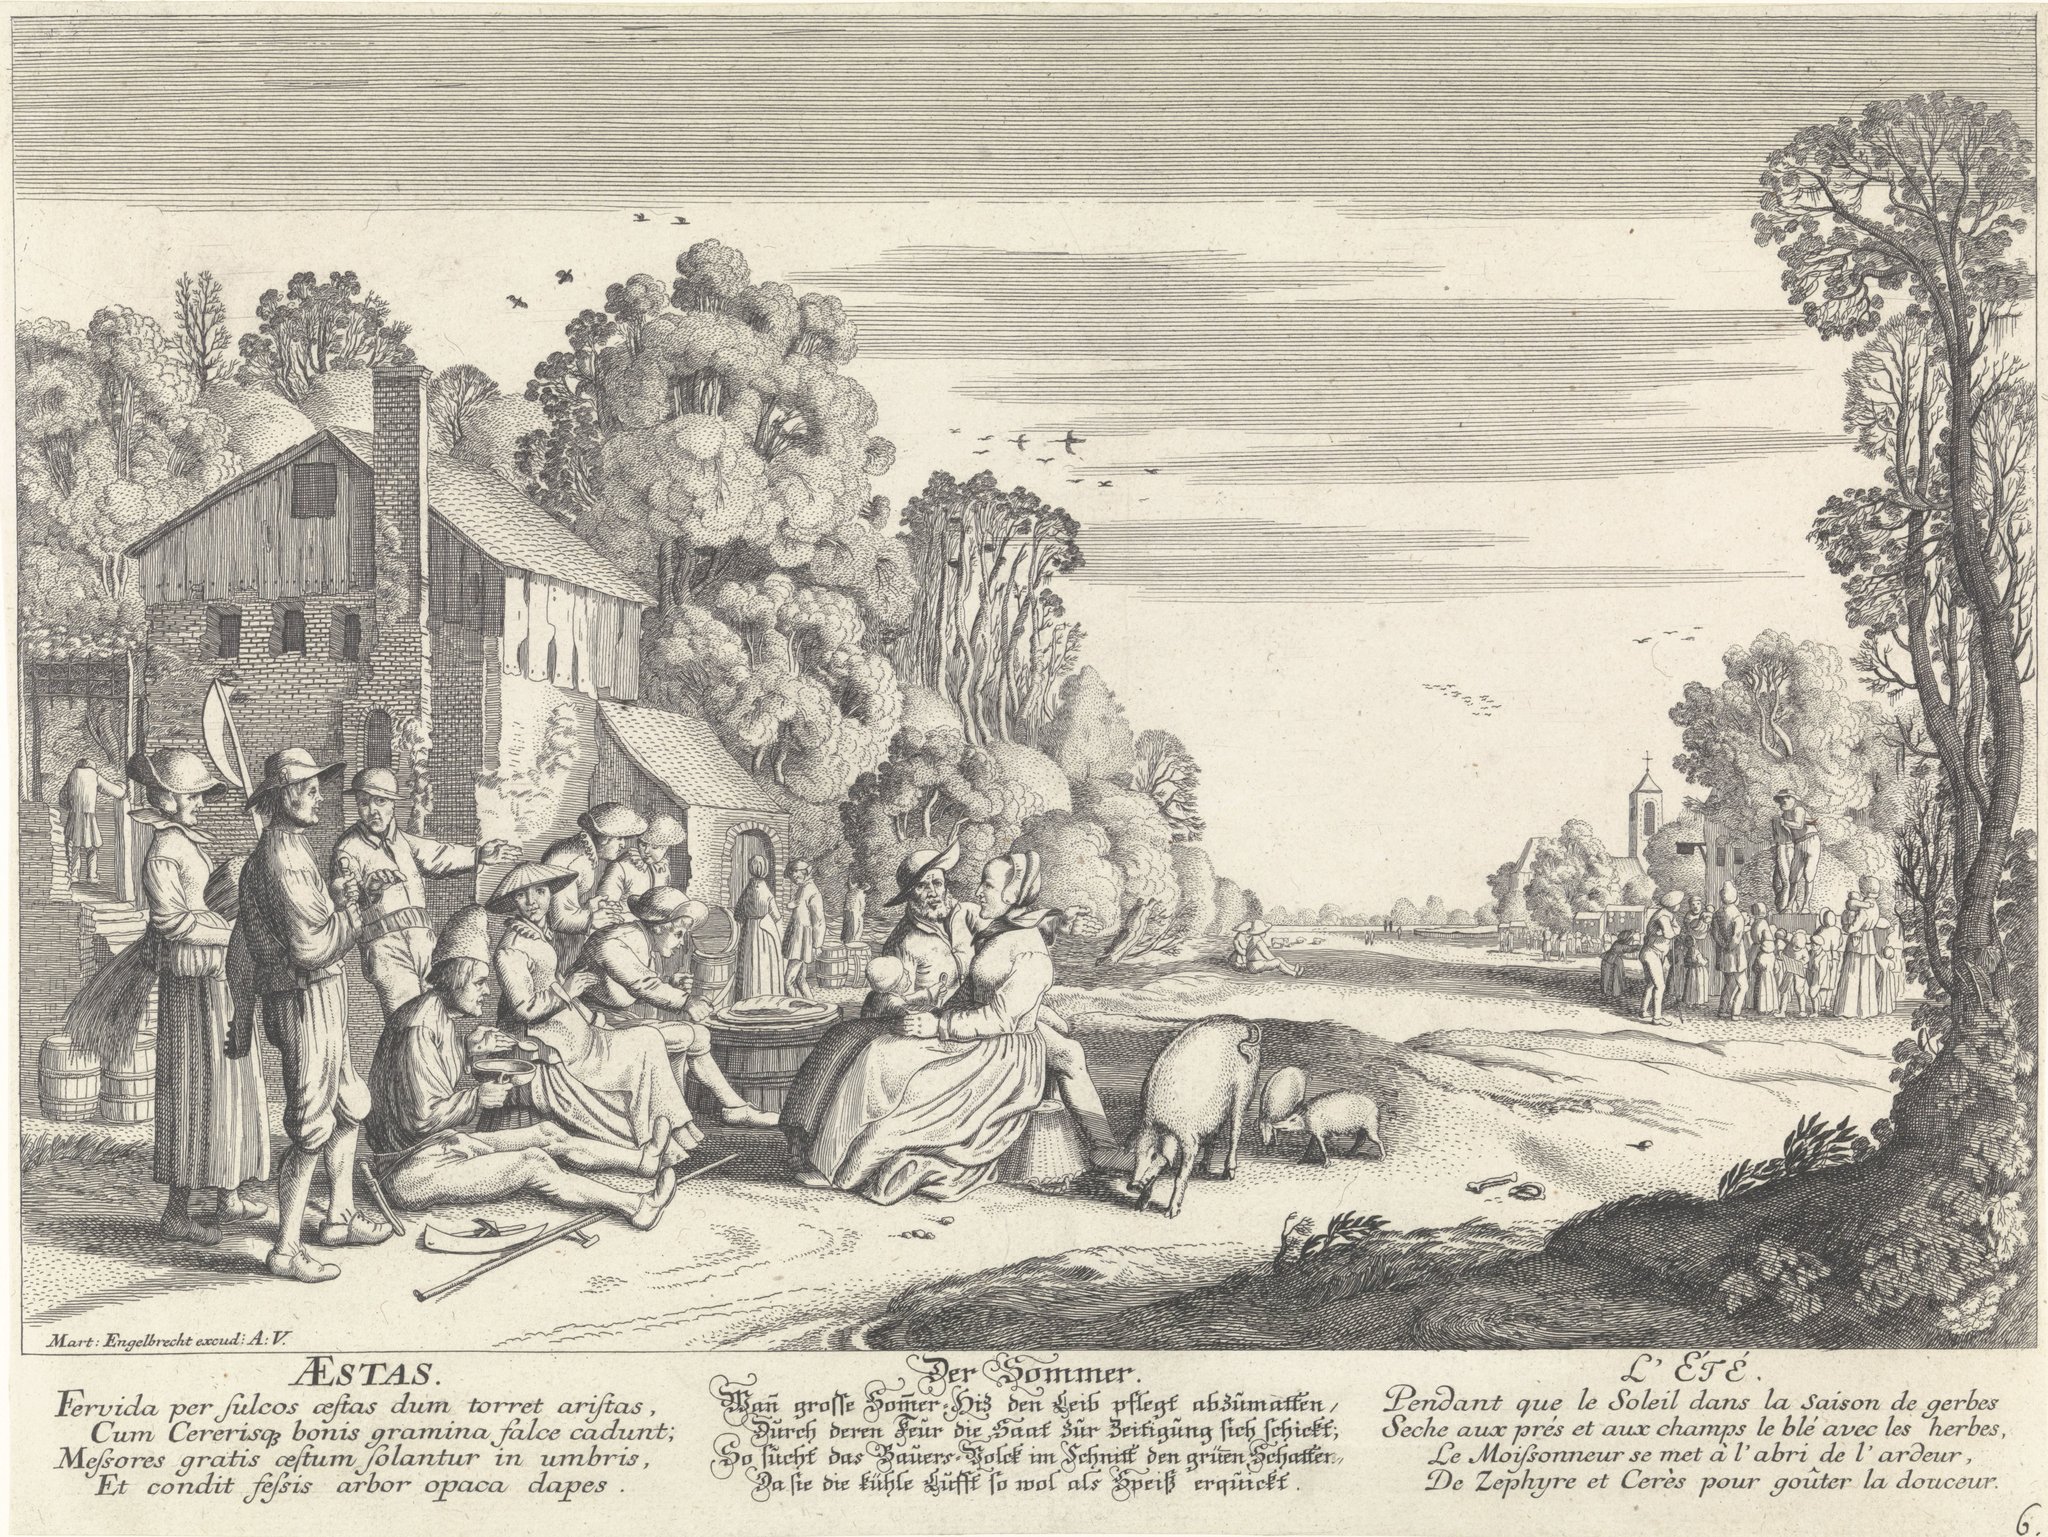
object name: print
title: Zomer (Aestas)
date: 1694-1756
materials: paper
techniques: engraving, etching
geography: augsburg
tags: summer, 'aestas'; 'estate' (ripa), summer landscape; landscape symbolizing summer (the four seasons of the year) (+ with scenes showing human occupations ~ seasons and months)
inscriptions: number: ‘6’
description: Etende en converserende figuren en een vrouw met een zeis bij een huis. Rechts een man met een vel papier in de hand bij toehoorders op een verhoging. Verbeelding van het jaargetijde zomer.